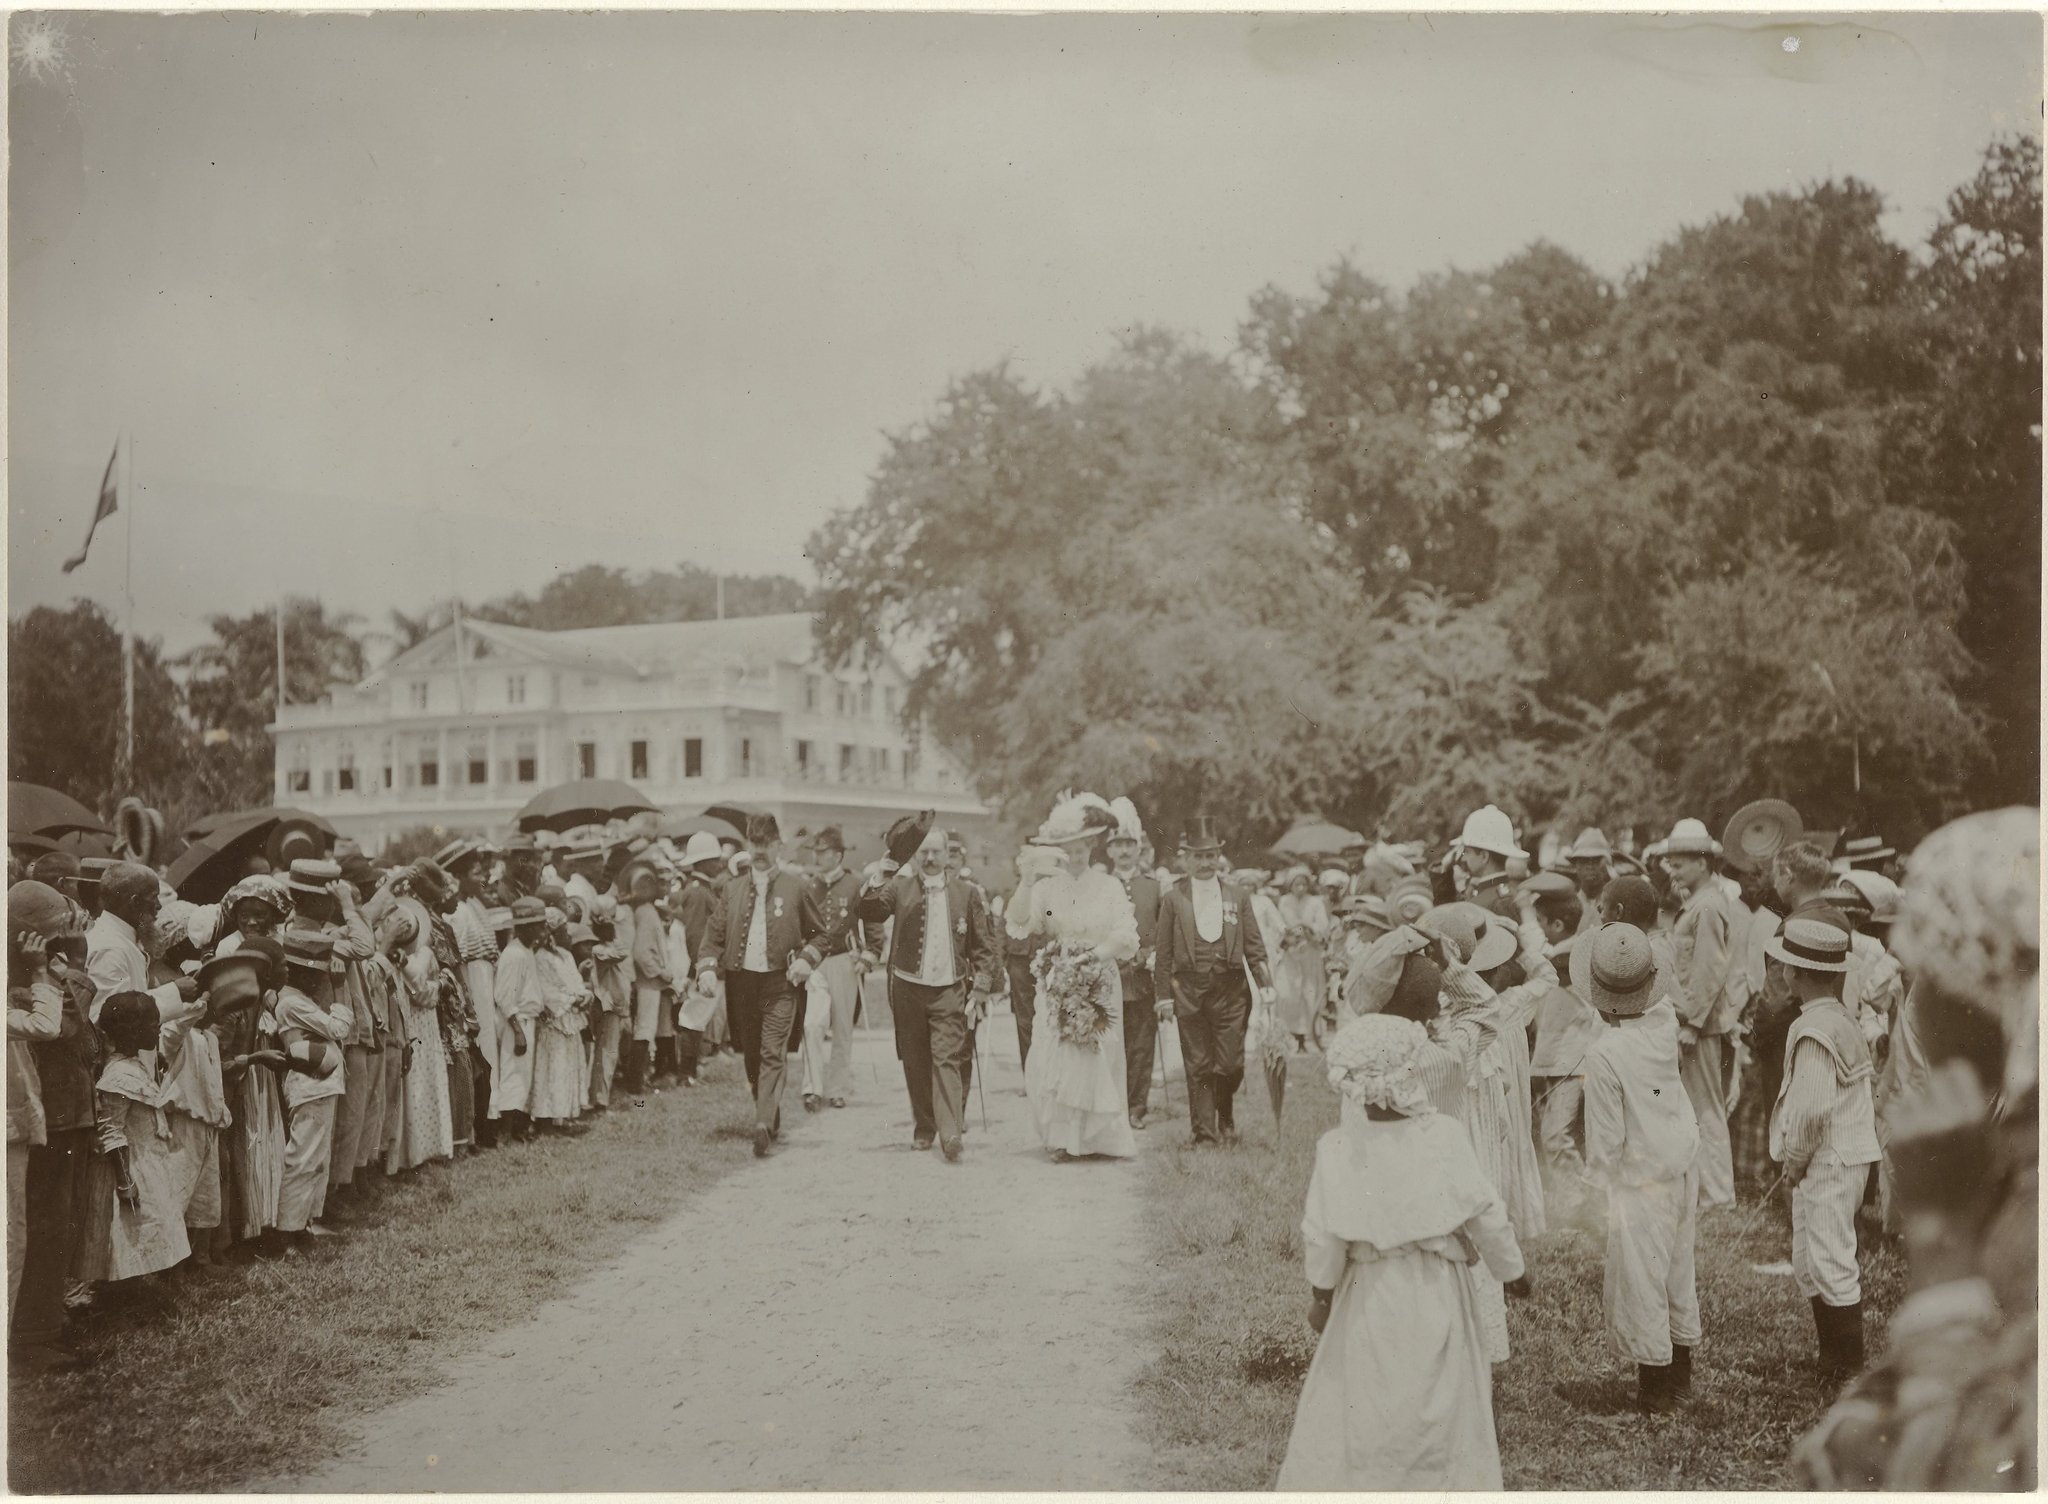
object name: photograph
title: Koninginnedag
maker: Anonymous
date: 1903-1908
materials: photographic support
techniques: photography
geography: paramaribo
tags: suriname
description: Door een tuin lopen P. Hofstede Crull en zijn vrouw, samen met andere hoogwaardigheidsbekleders. Langs de kant staan mensen. Hofstede Crull was op dit moment waarschijnlijk waarnemend Gouverneur van Suriname. Koninginnedag te Paramaribo.